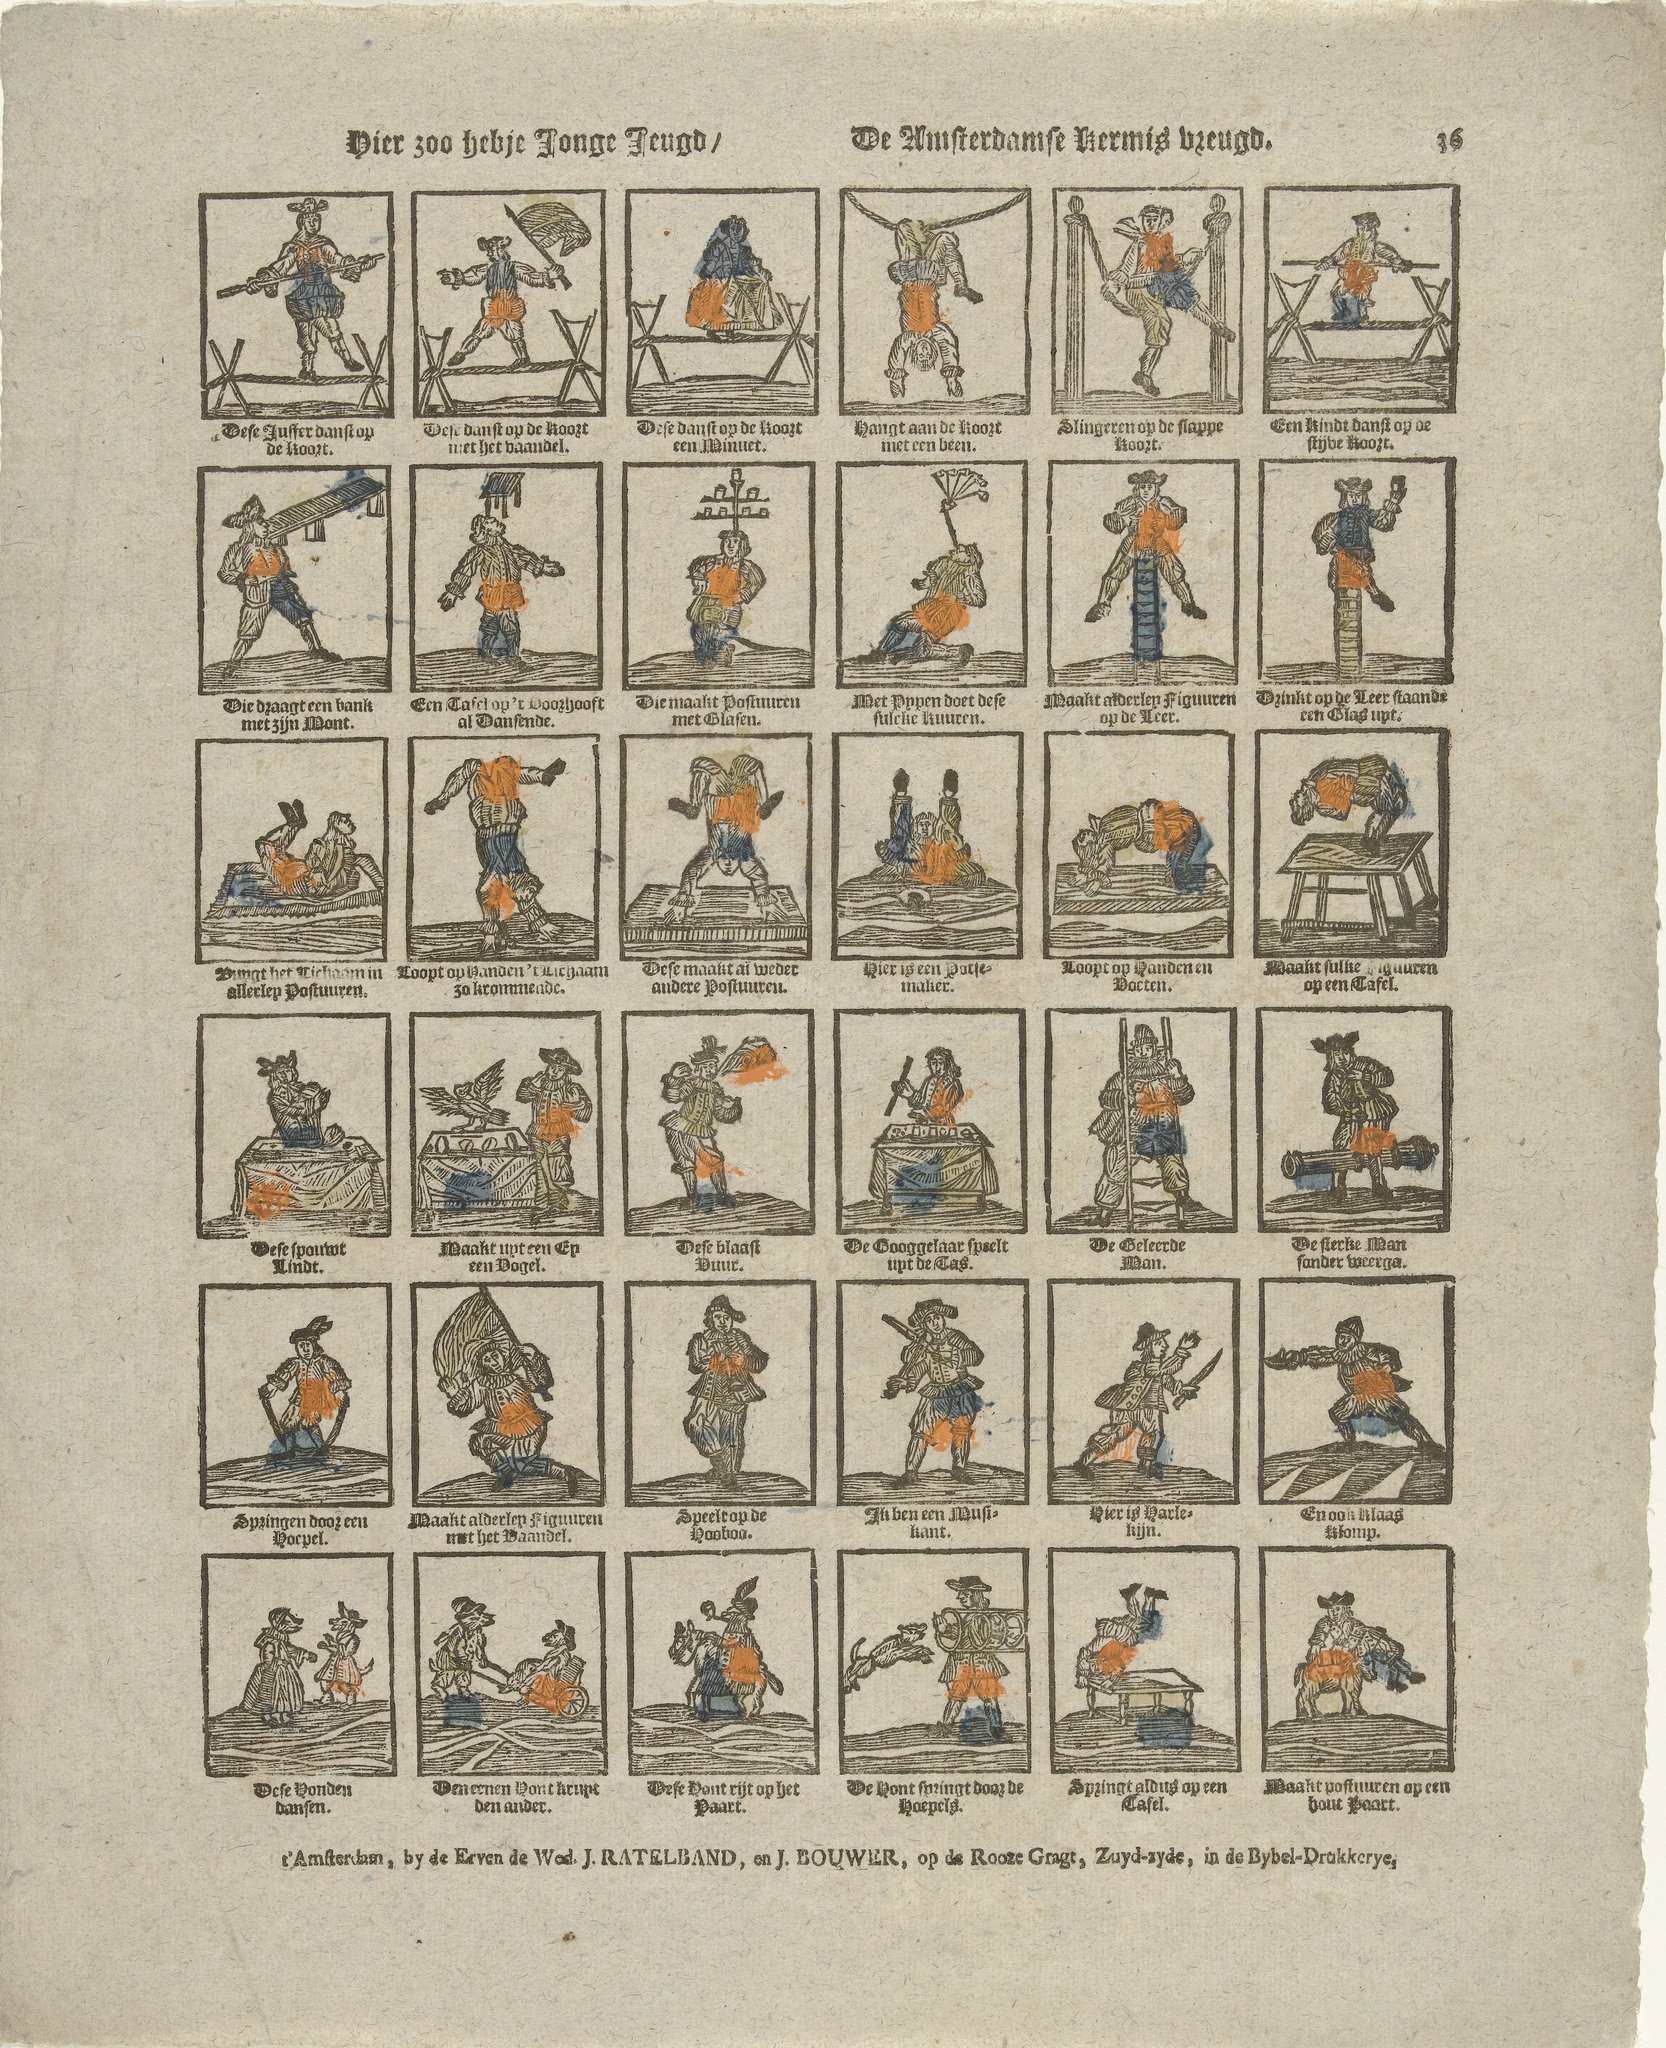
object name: popular print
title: Hier zoo hebje jonge jeugd / De Amsterdamse kermis vreugd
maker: Anonymous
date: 1782-1793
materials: paper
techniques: colour, letterpress printing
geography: amsterdam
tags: (annual) fair, trade fair, pleasure fair and circus, amsterdam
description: Blad met 36 voorstellingen over de Amsterdamse kermis: koorddansers, acrobaten, goochelaar, muzikanten etc. Onder elke afbeelding een onderschrift. Genummerd rechtsboven: 36.